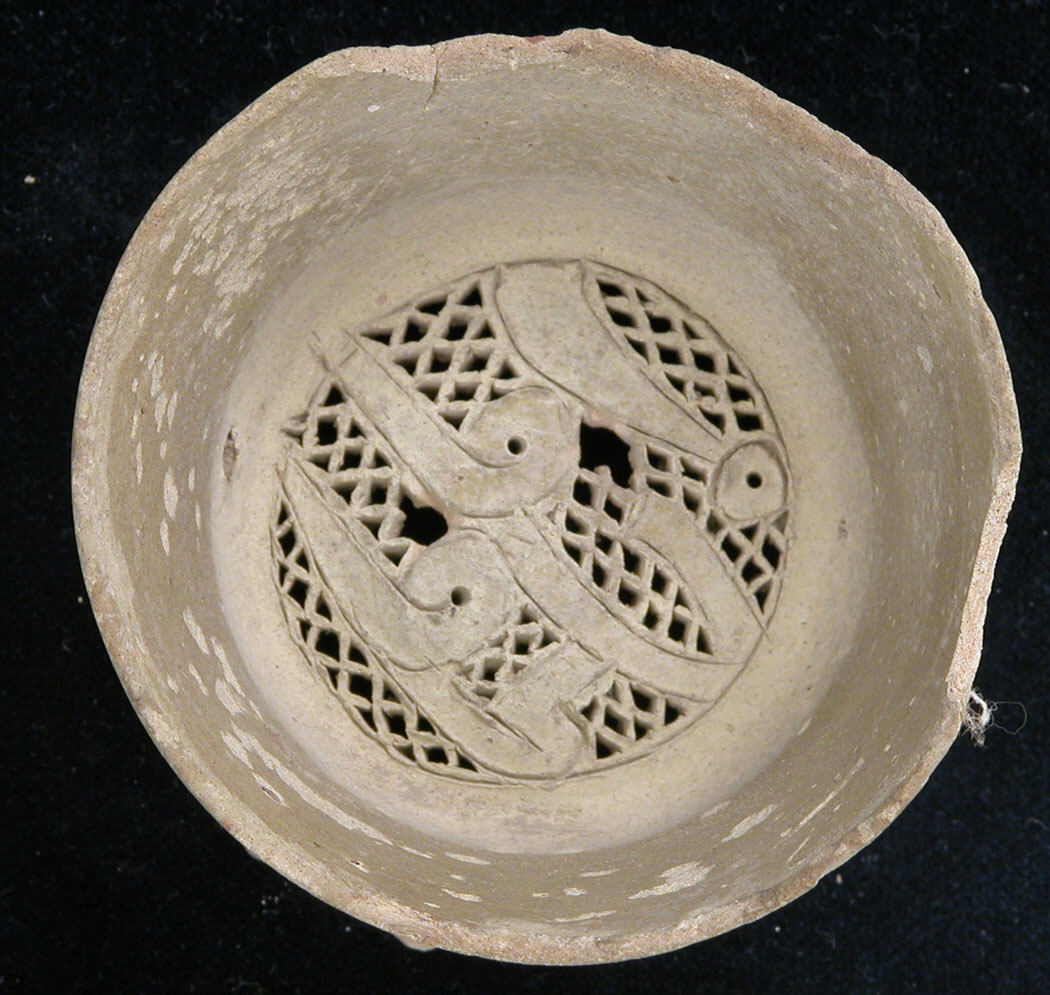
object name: water filter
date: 901-1200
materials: earthenware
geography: egypt